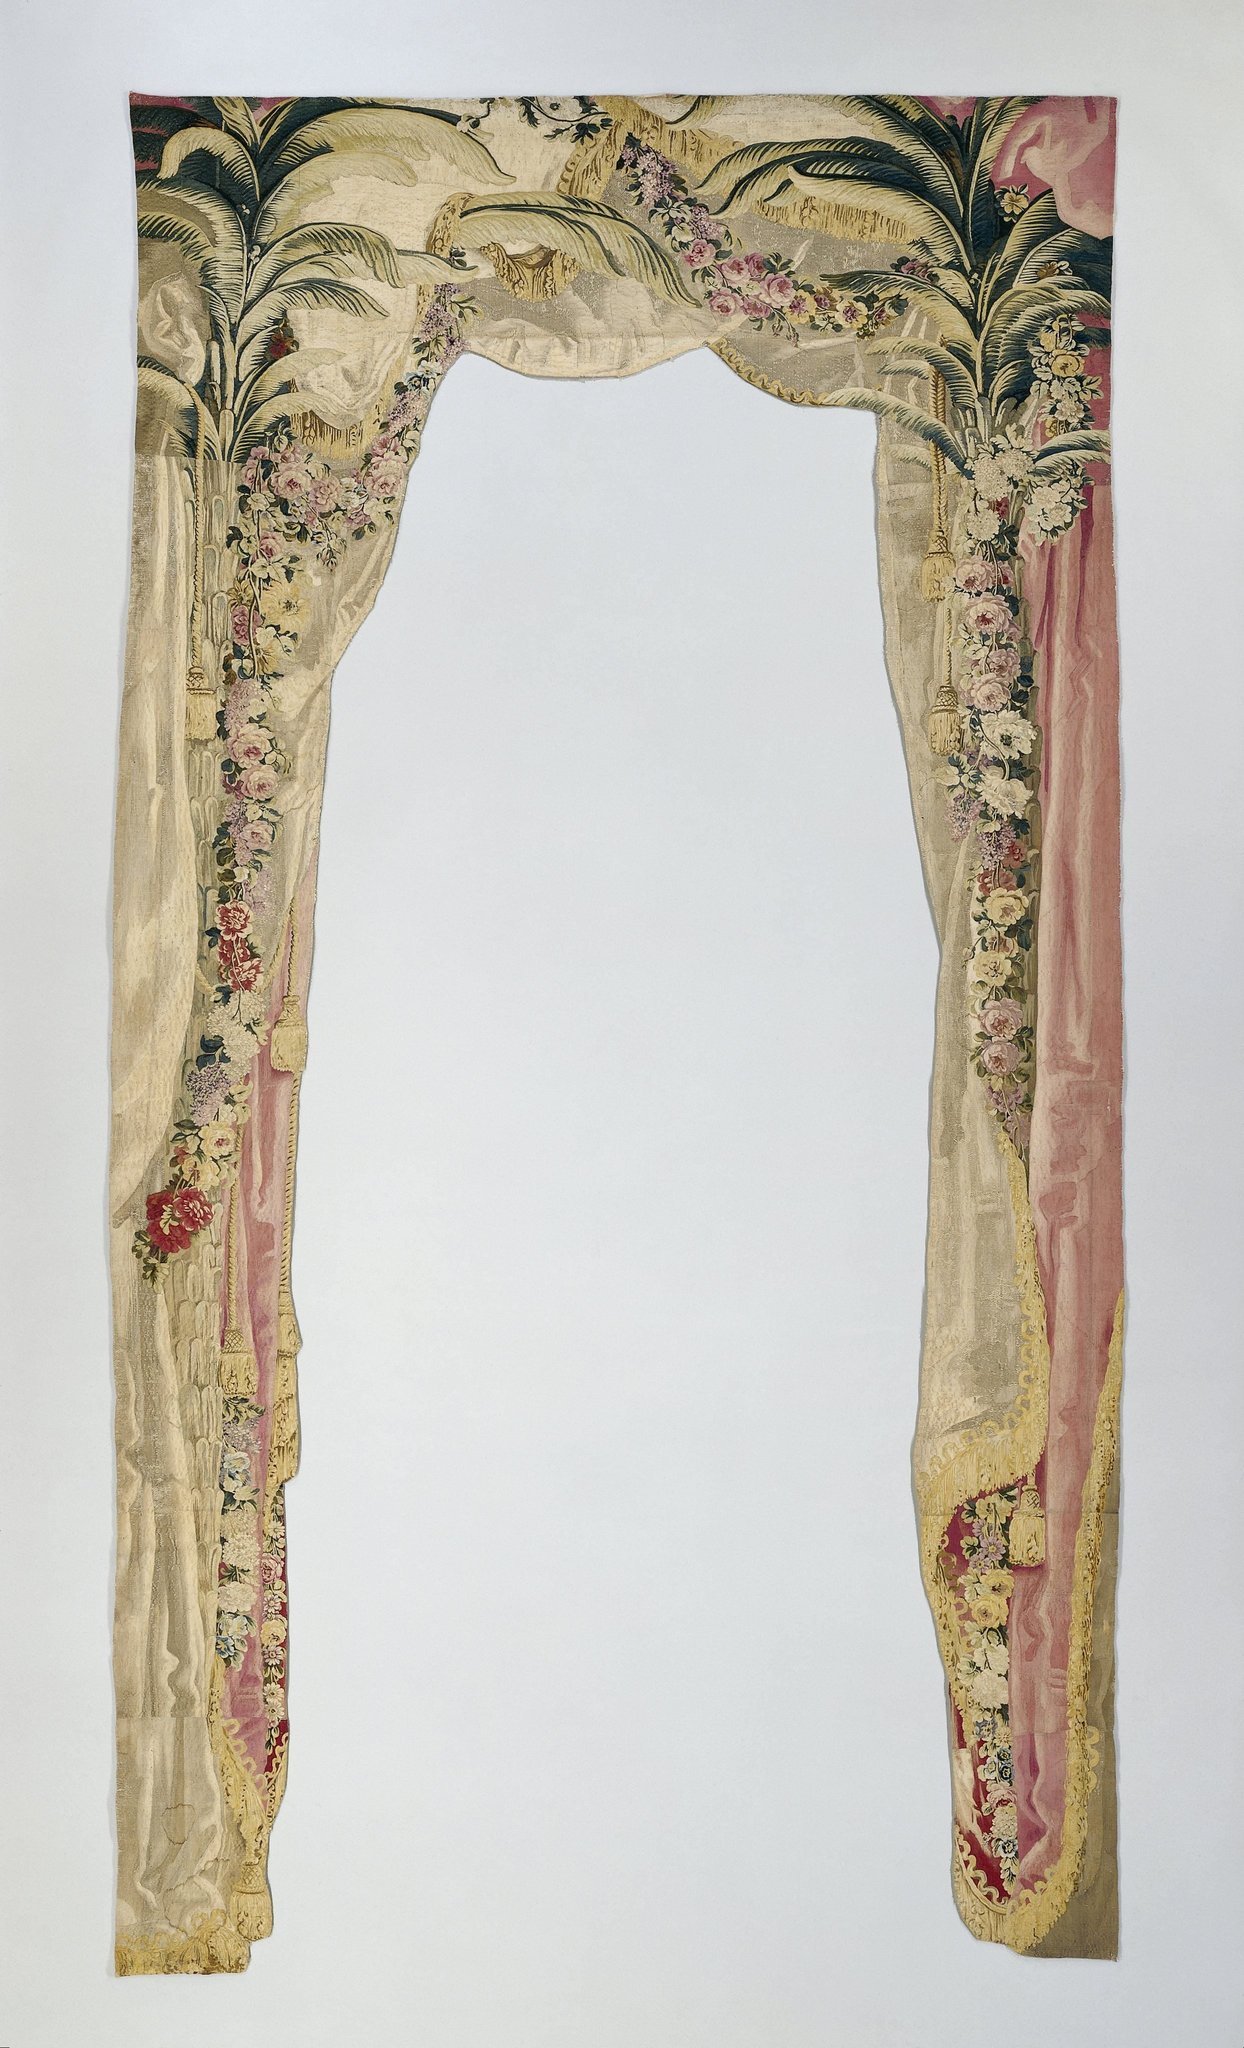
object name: cantonnière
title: Cantonnière met draperieën, palmbomen en bloemguirlandes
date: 1860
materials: silk, wool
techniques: tapestry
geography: beauvais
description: Cantonnière met gordijn- en palmmotieven.